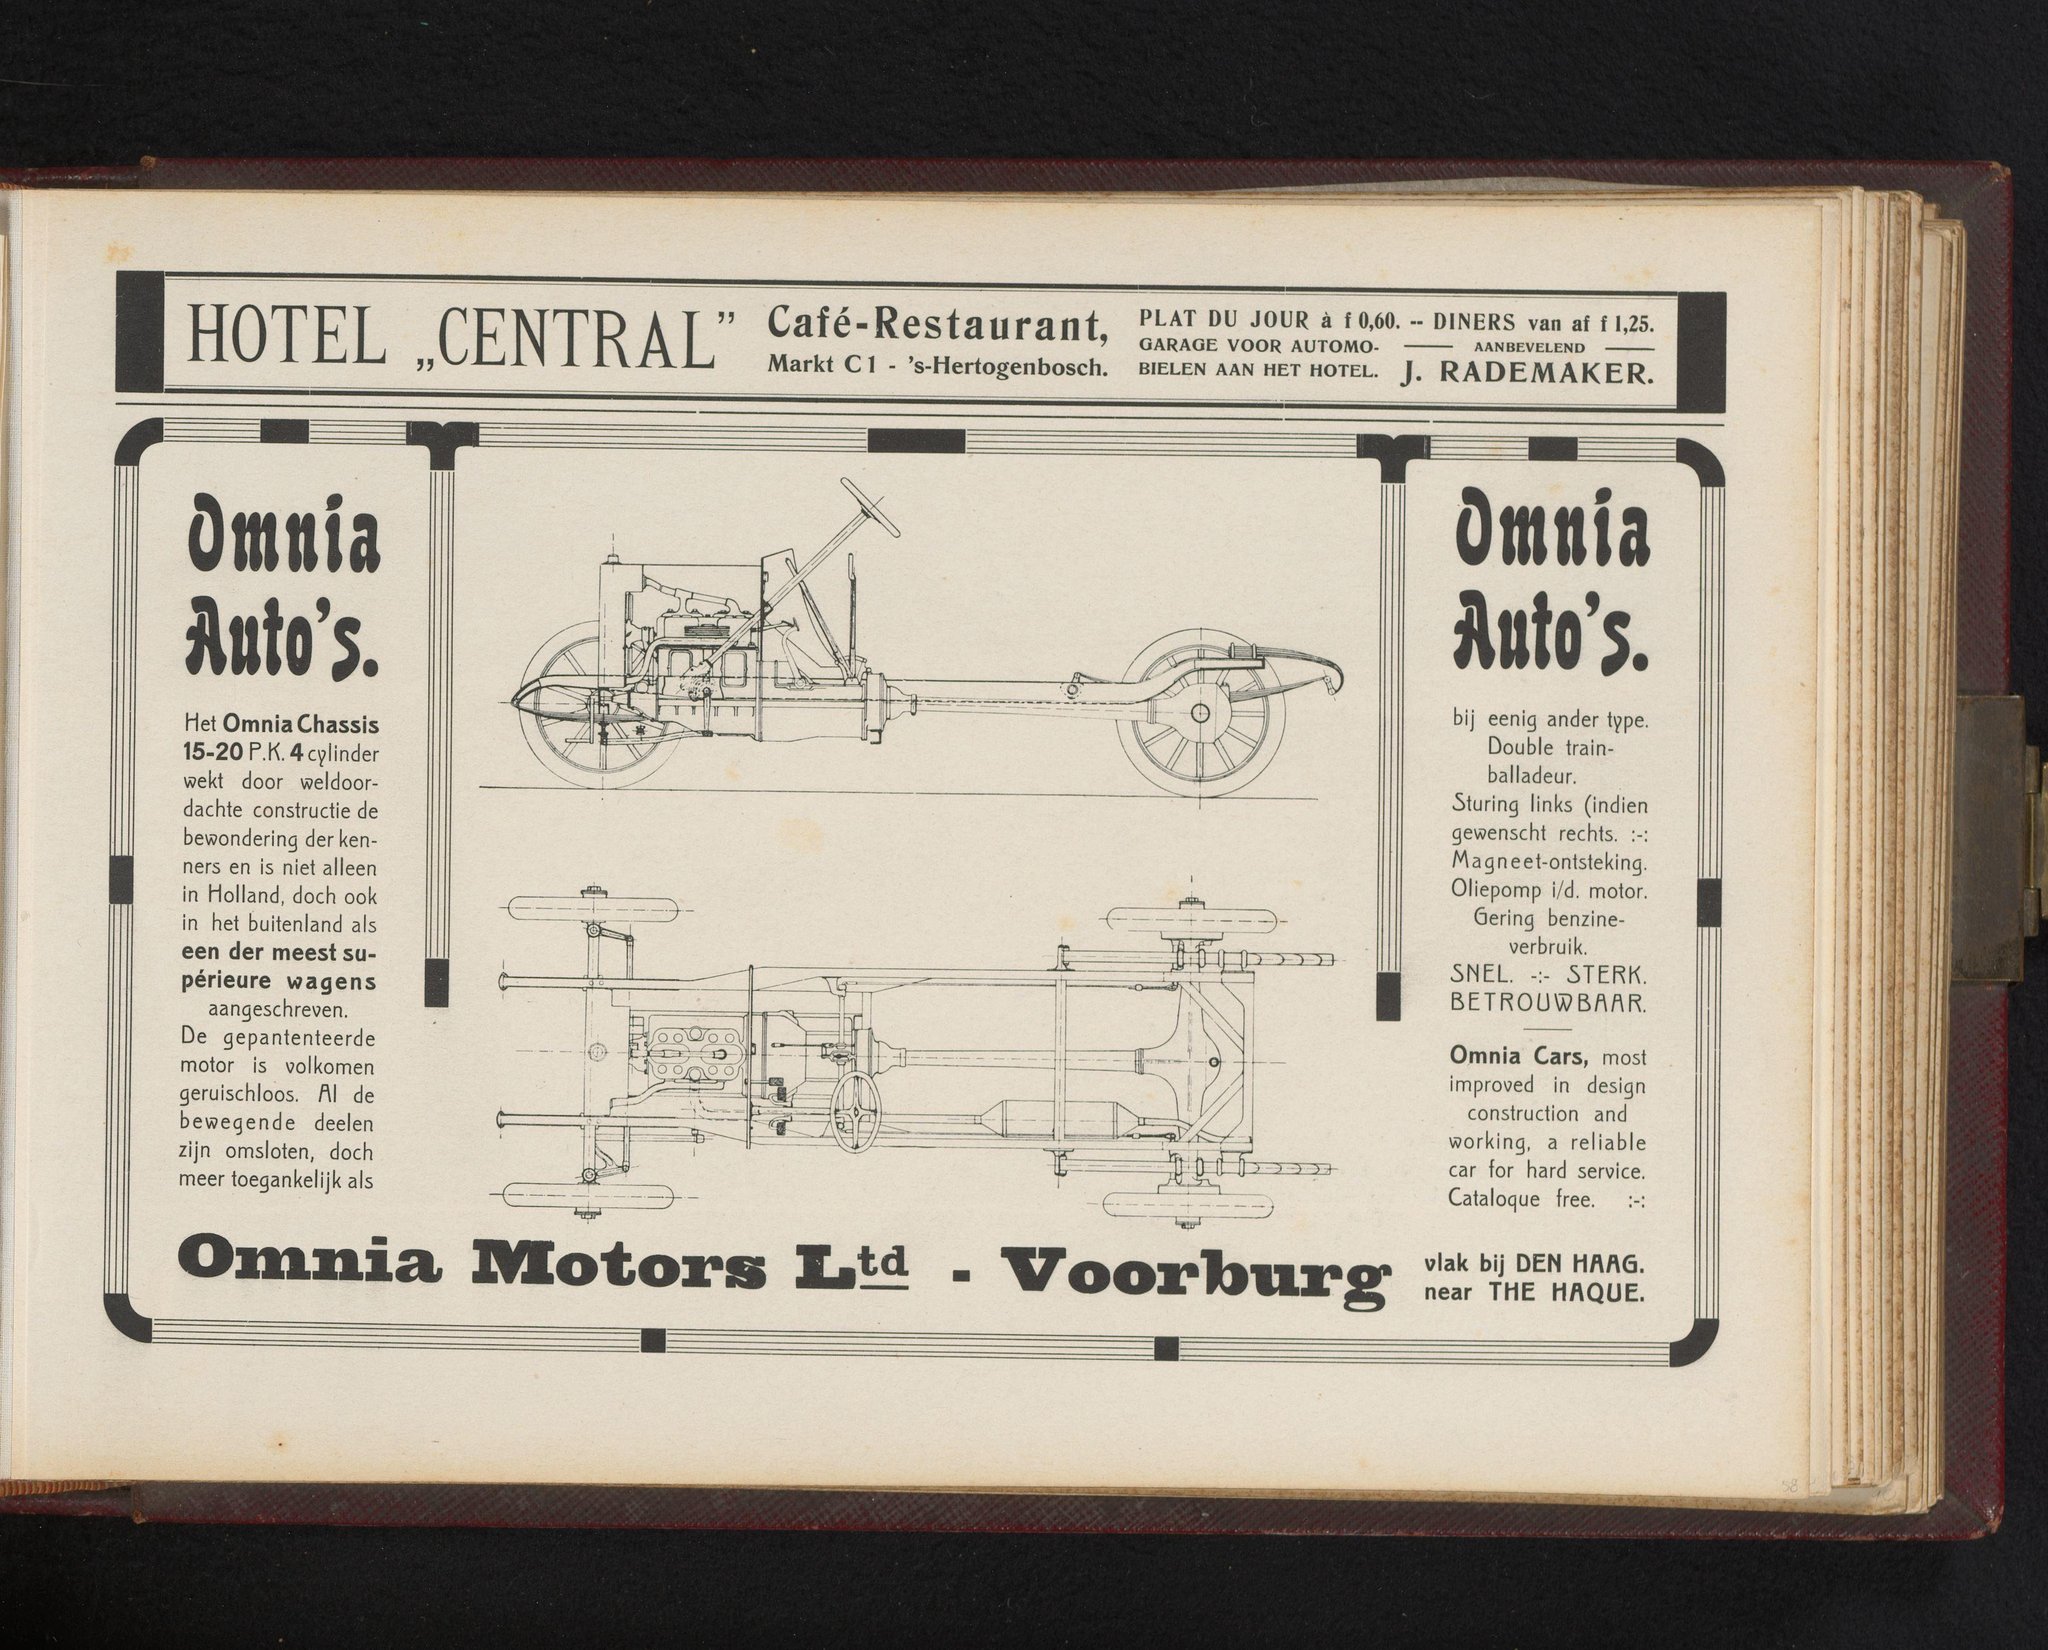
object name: album leaf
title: Advertenties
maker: Anonymous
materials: paper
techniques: printing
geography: netherlands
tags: advertising, automobile, painting, drawing and the graphic arts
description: Advertenties voor Hotel Central en Omnia Motors Ltd. Deze pagina maakt deel uit van een album.